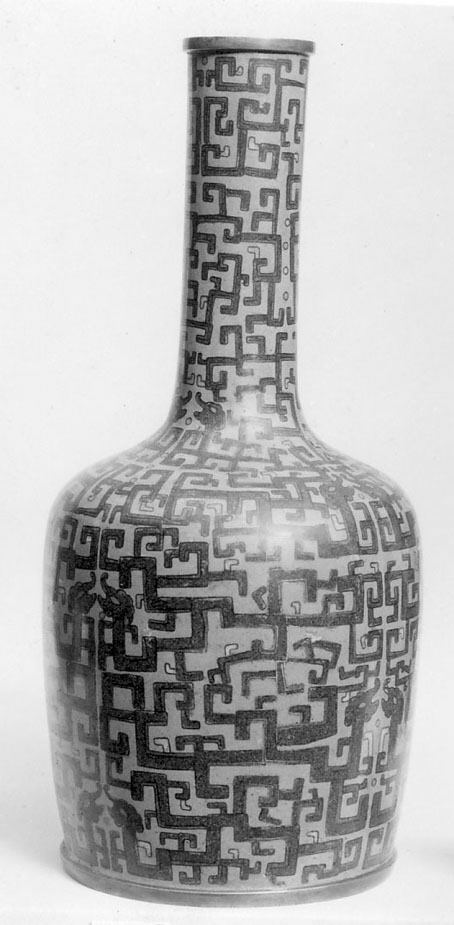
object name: bottle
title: Bottle (one of a pair)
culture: chinese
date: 1662-1722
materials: copper, enamel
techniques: enamel